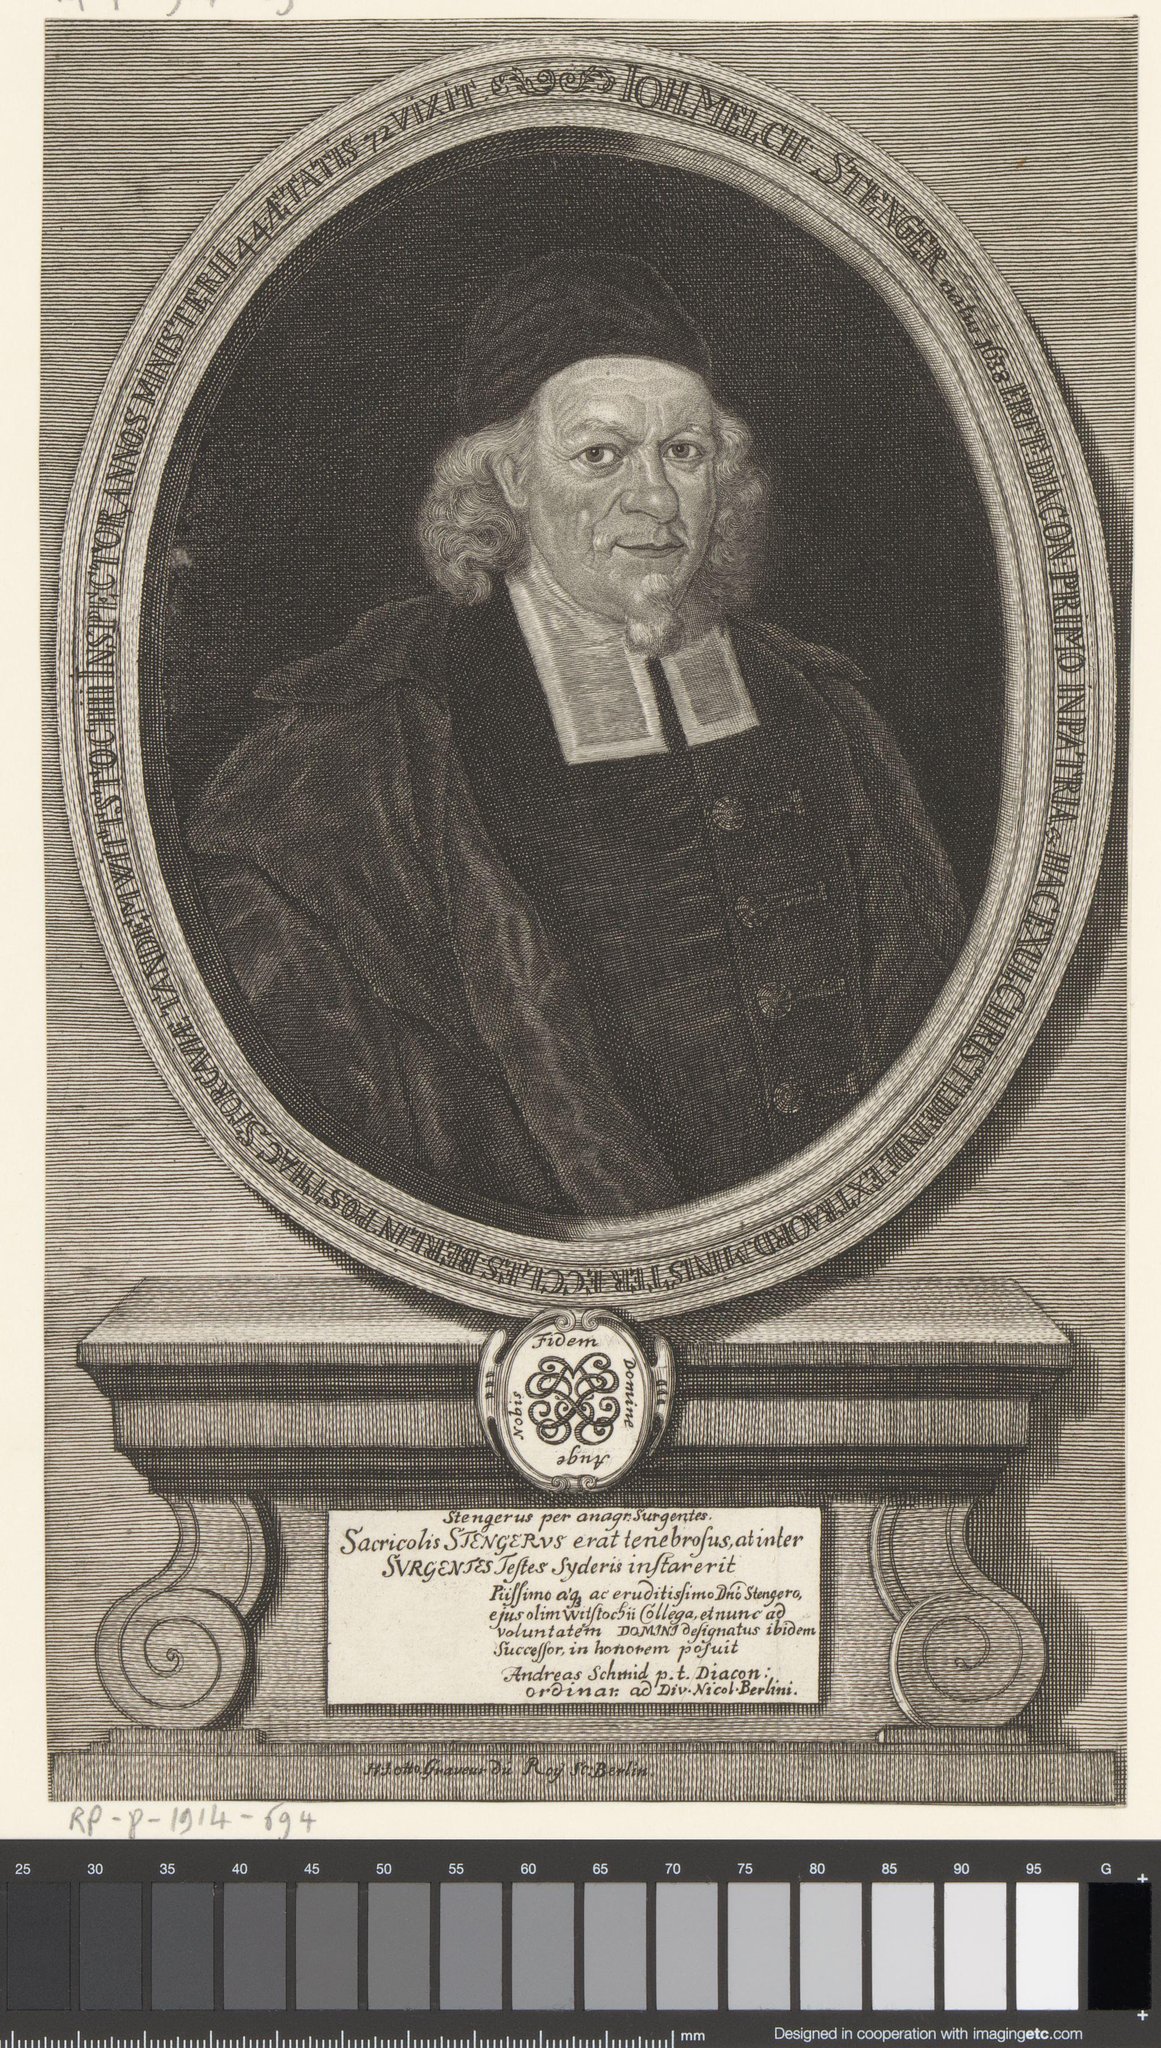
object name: print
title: Portret van Joh. Melchior Stenger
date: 1653-1749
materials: paper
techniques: engraving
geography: berlin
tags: germany, historical persons, berlin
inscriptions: collector's mark: Lugt 2228